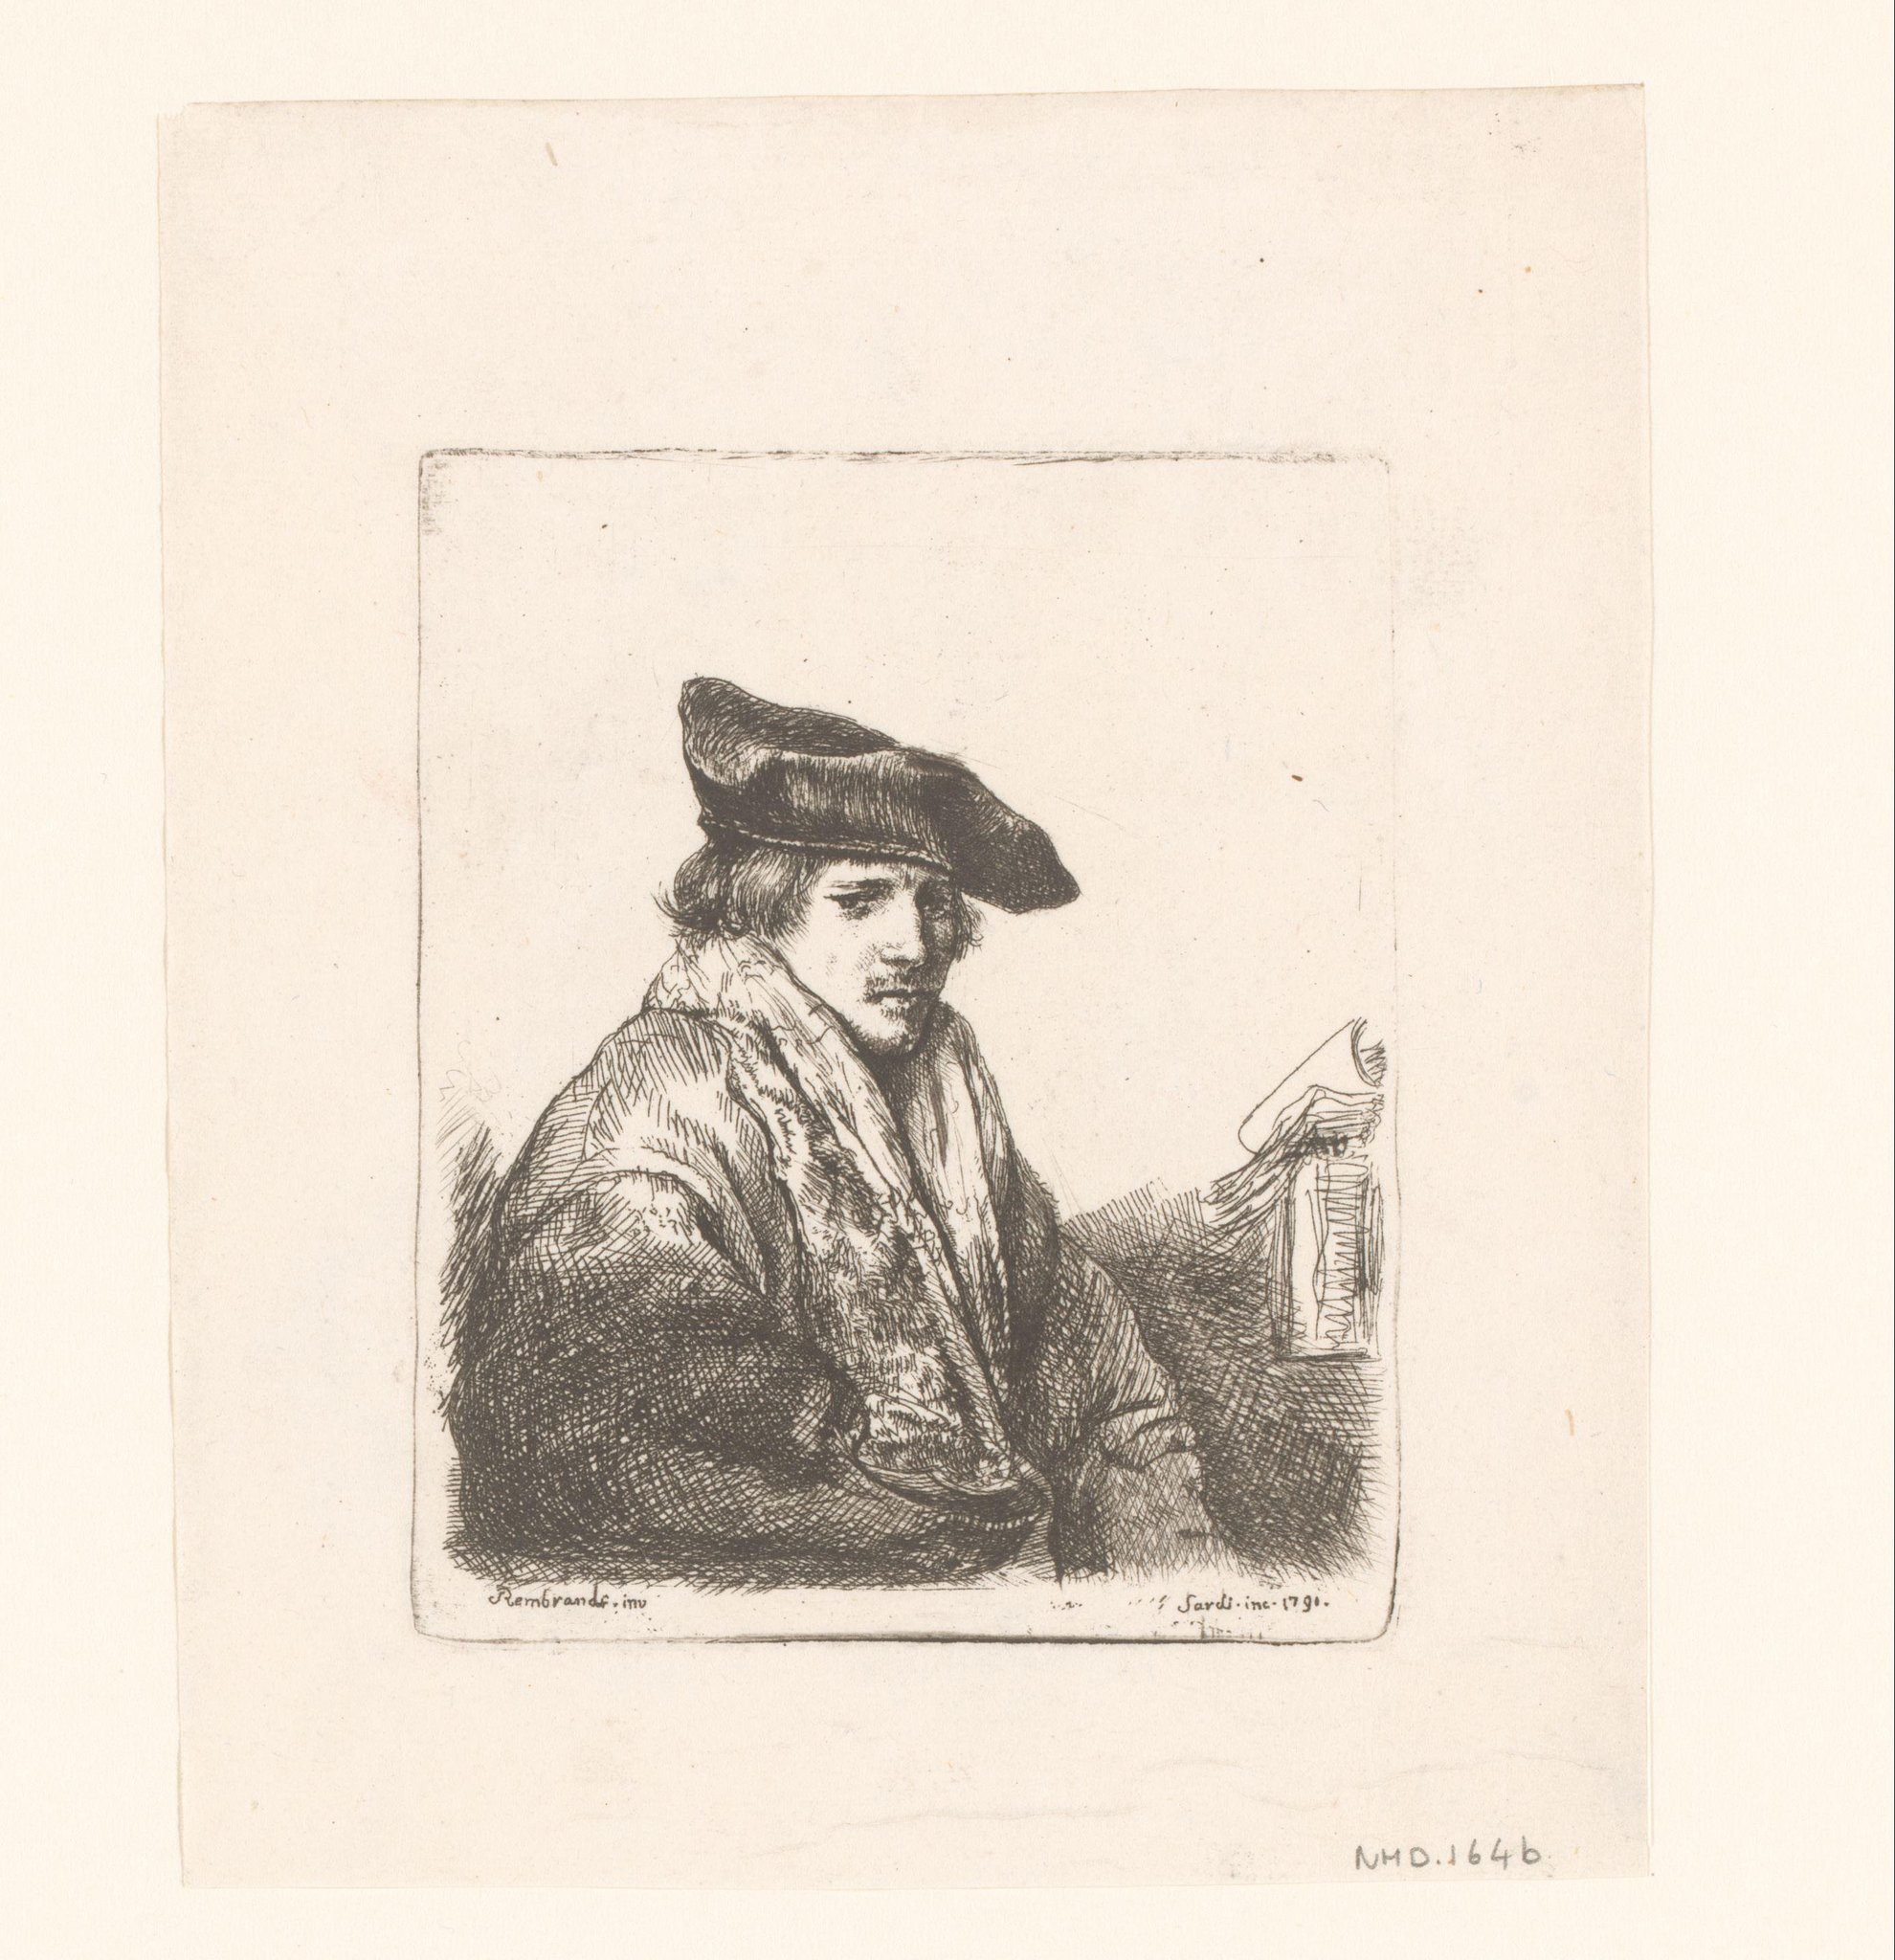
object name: print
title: Young man in a velvet cap (Petrus Sylvius?)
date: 1791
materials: paper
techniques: etching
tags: youth, adolescent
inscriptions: collector's mark: Lugt 2760, collector's mark: Lugt 2228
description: Mogelijk een portret van Petrus Johannes Sylvius.